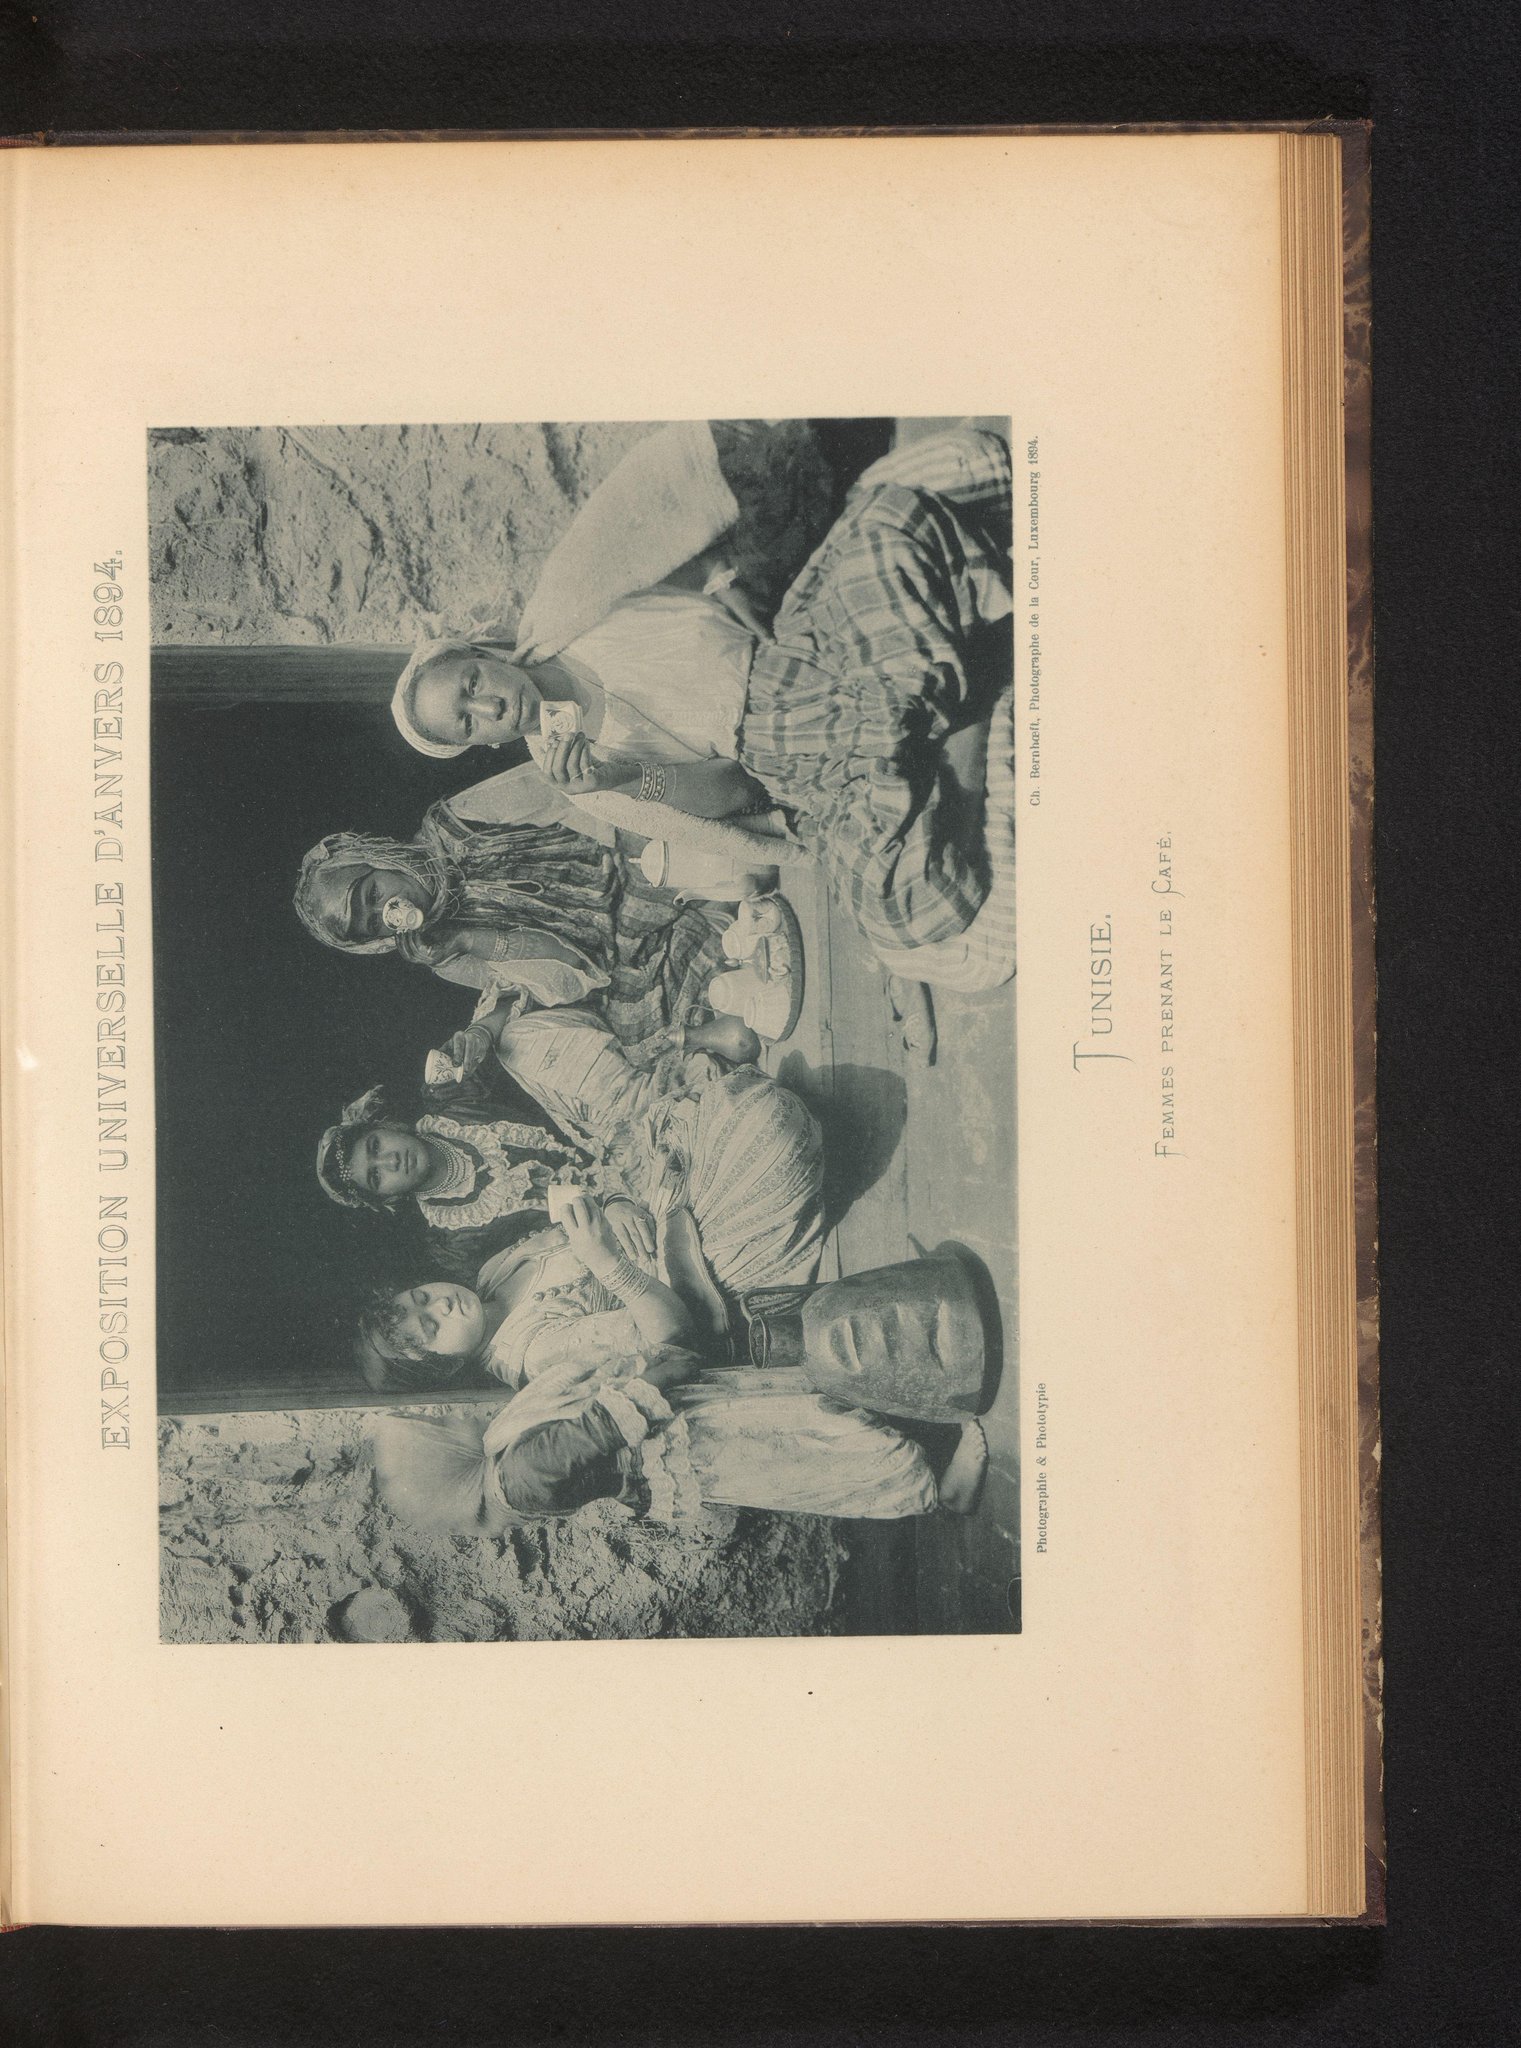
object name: photomechanical print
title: Vier vrouwen drinken koffie in het Tunesische deel van de Wereldtentoonstelling van Antwerpen in 1894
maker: charles bernhoeft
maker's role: publisher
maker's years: 1859-1933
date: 1894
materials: paper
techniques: photograph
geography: antwerp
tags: adult woman, world fair, world exhibition, child, cup of coffee, antwerp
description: Prent op derde ongenummerde pagina na pagina 90.